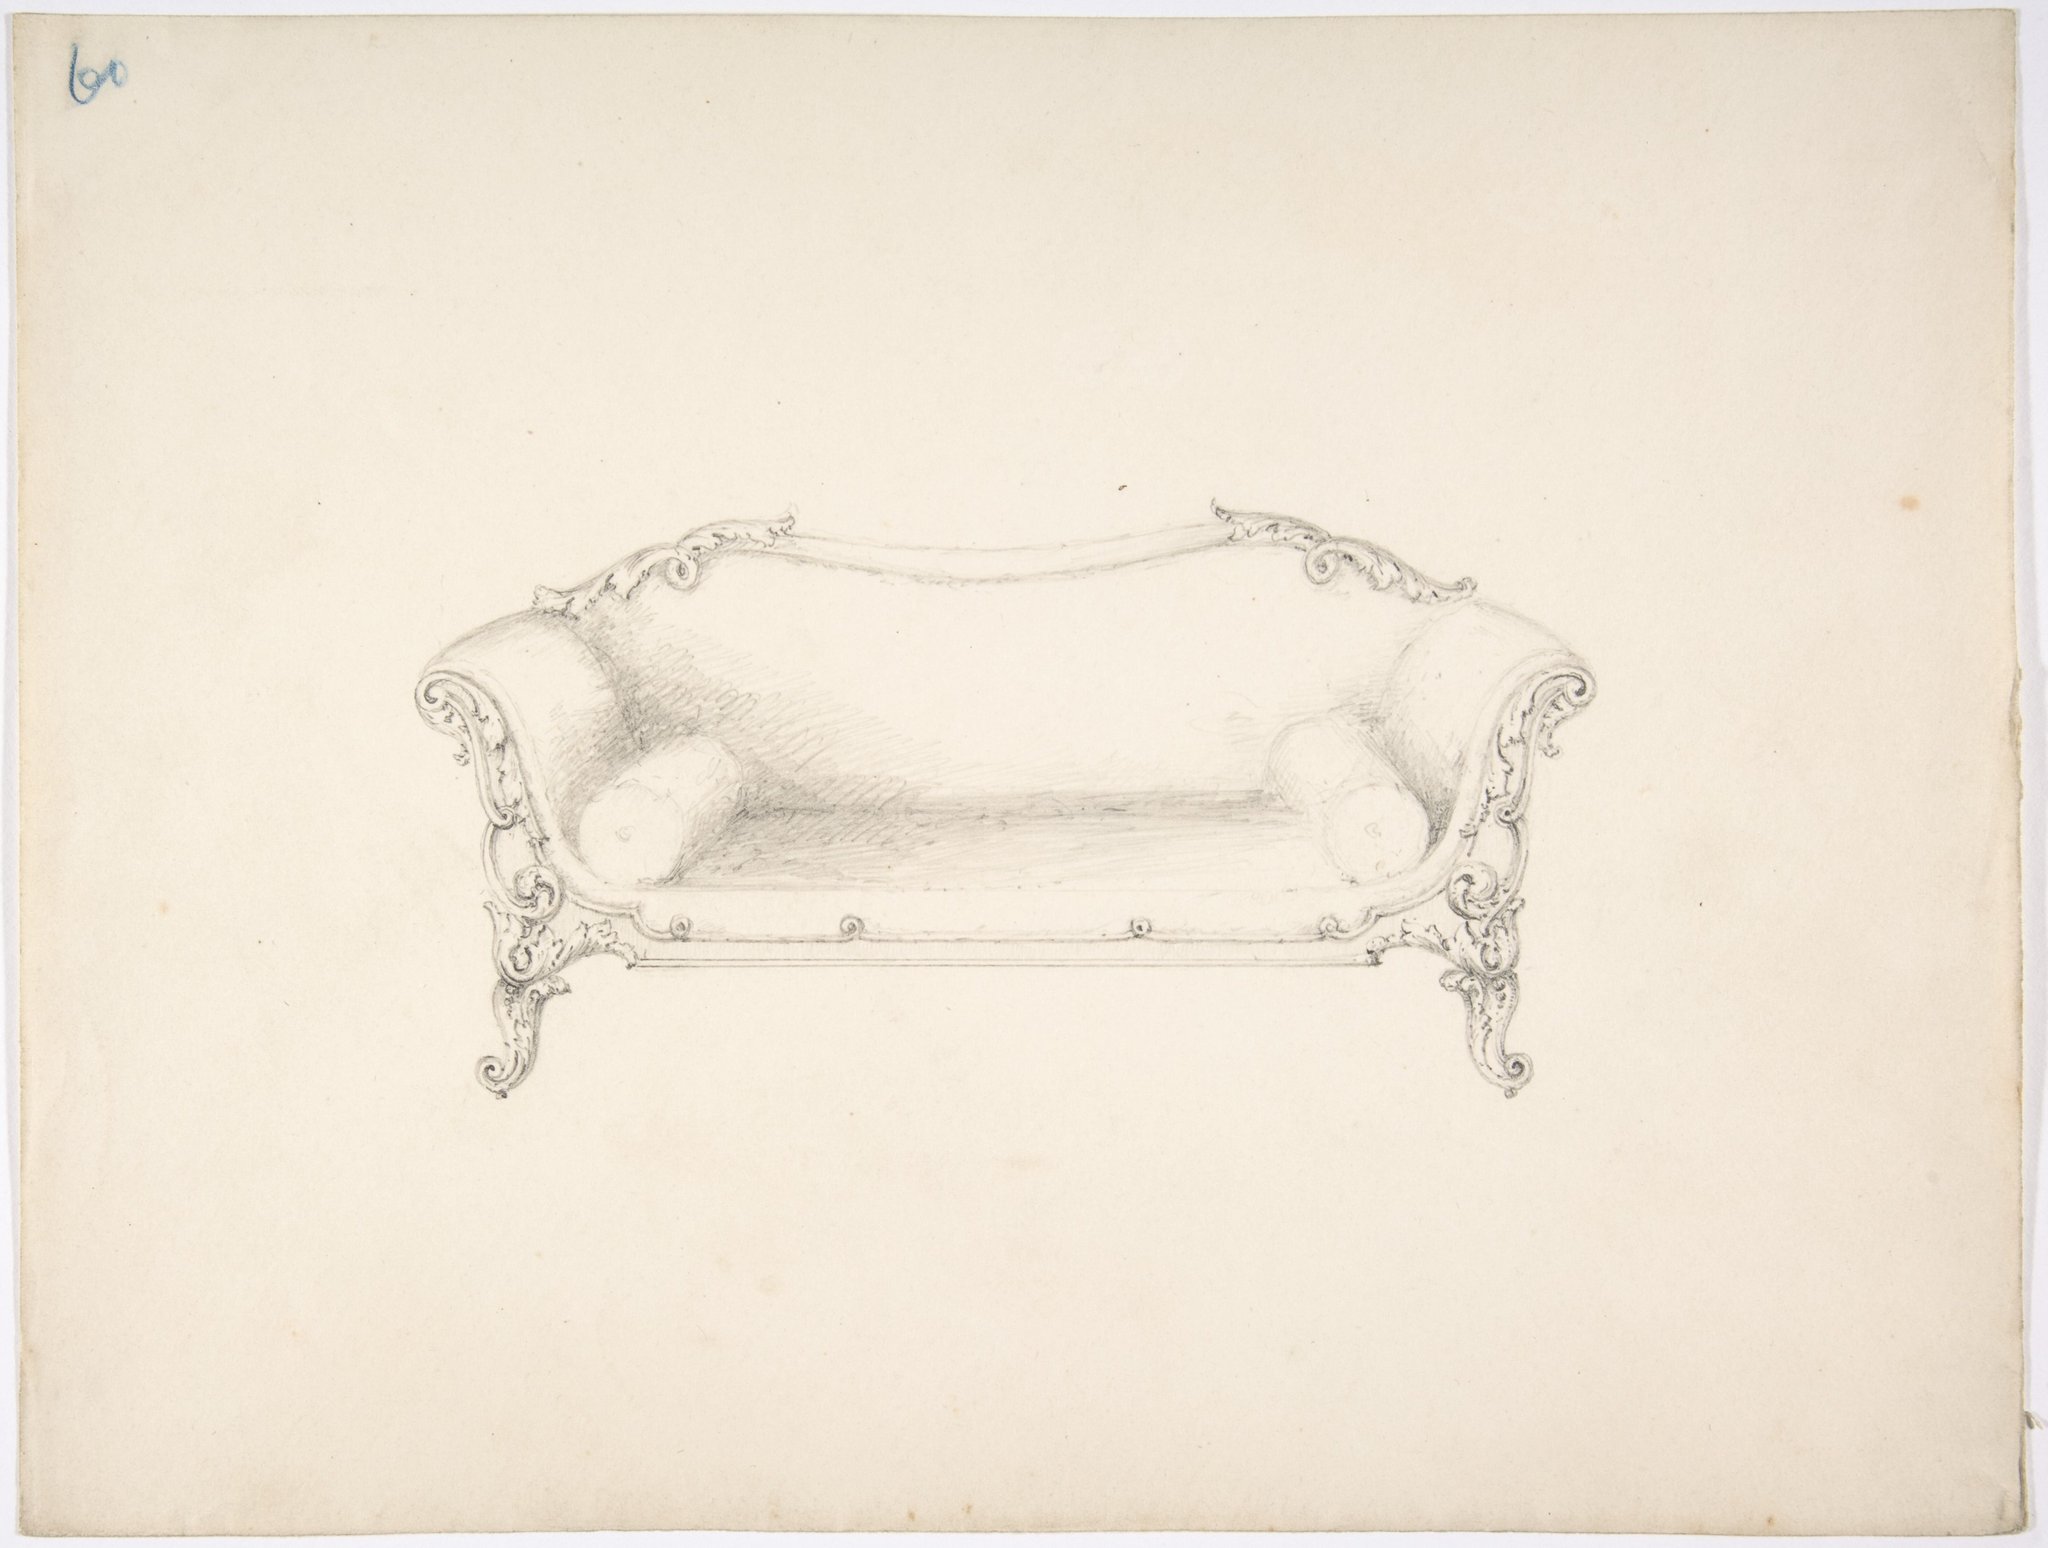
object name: drawing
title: Design for a Sofa with Foliate Ornament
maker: anonymous, british, 19th century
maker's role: artist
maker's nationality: british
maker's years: 1800-1900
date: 1801-1833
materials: graphite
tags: ornament,couches